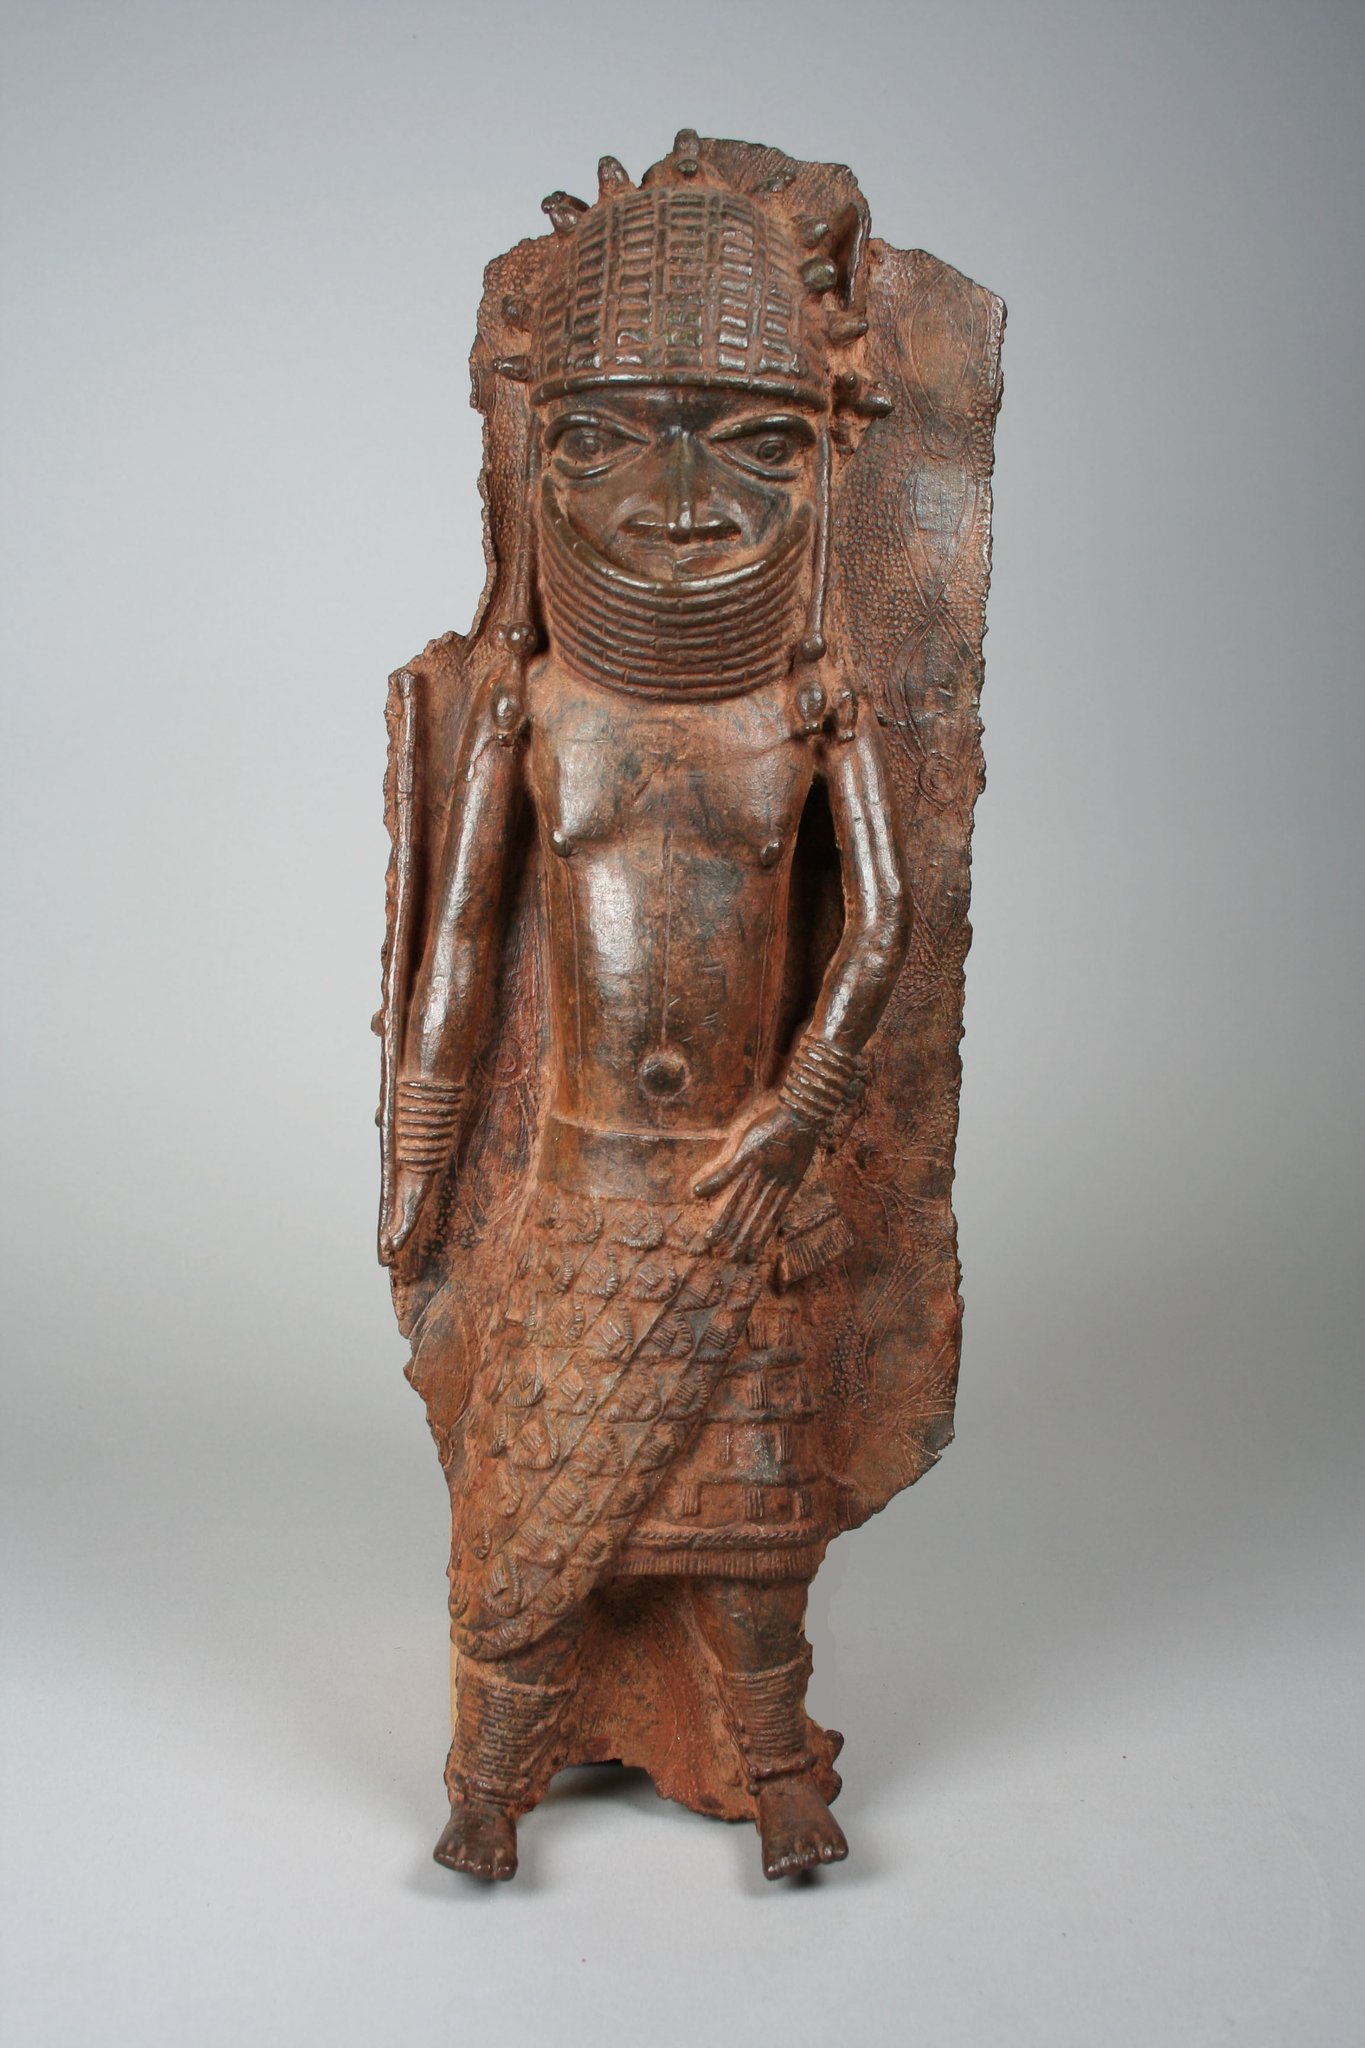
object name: plaque fragment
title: Plaque Fragment with Warrior Chief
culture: edo period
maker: ìgùn ẹ́rọ̀nwwọ̀n (brass-casting guild) artists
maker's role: artist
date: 1540-1570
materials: brass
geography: nigeria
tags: men,warriors